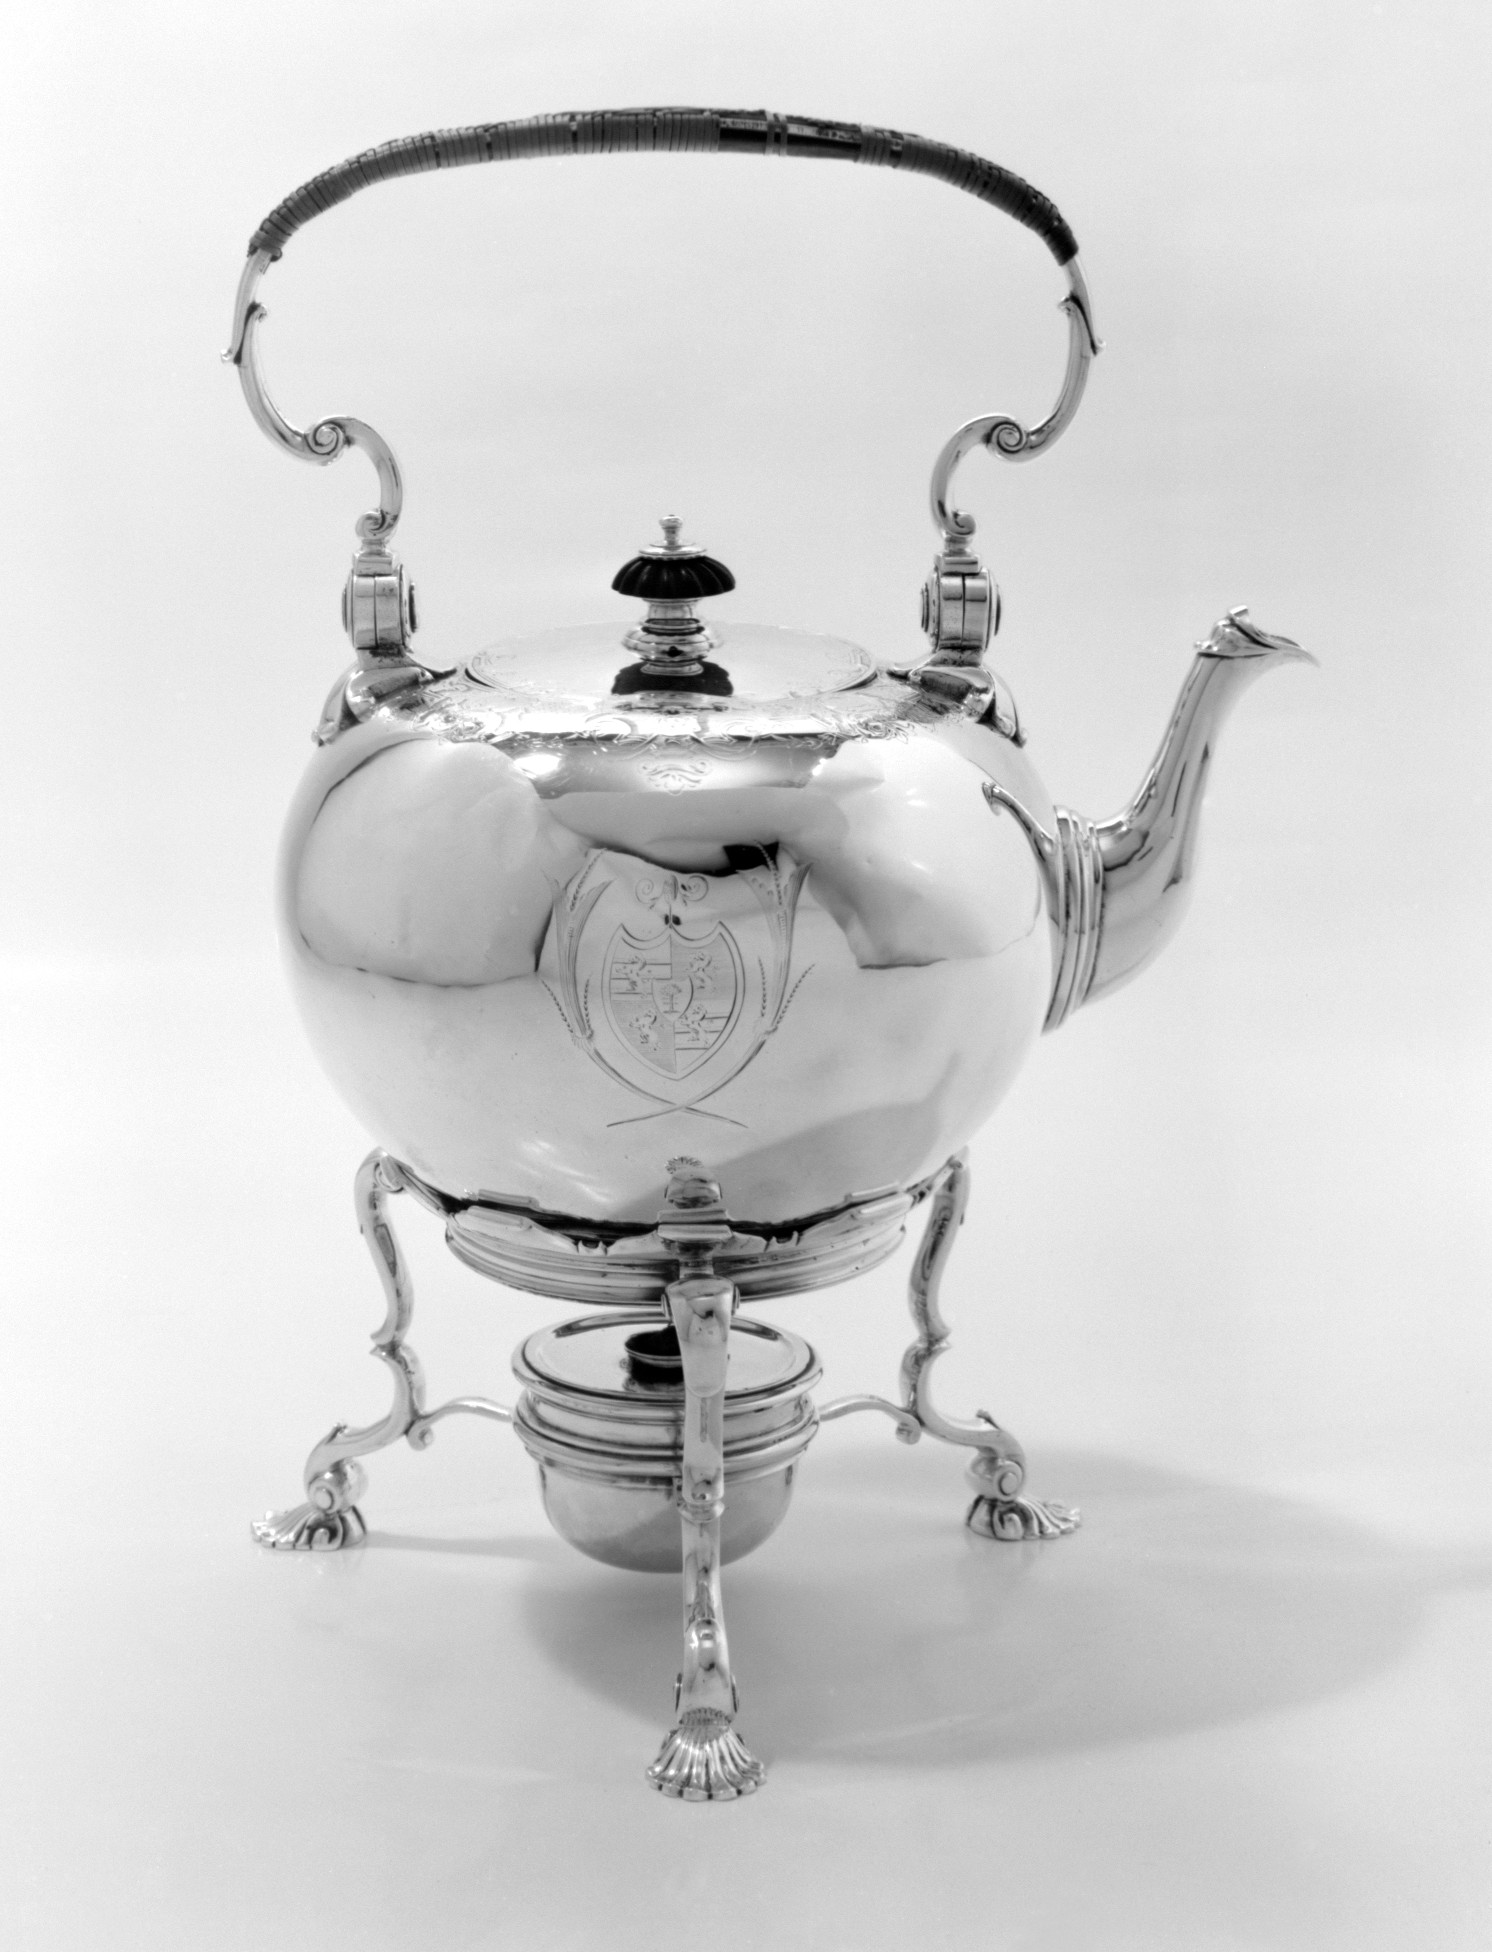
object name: hot water kettle with stand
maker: thomas farrer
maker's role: maker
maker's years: 1720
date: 1734-1735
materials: silver, wood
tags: coat of arms